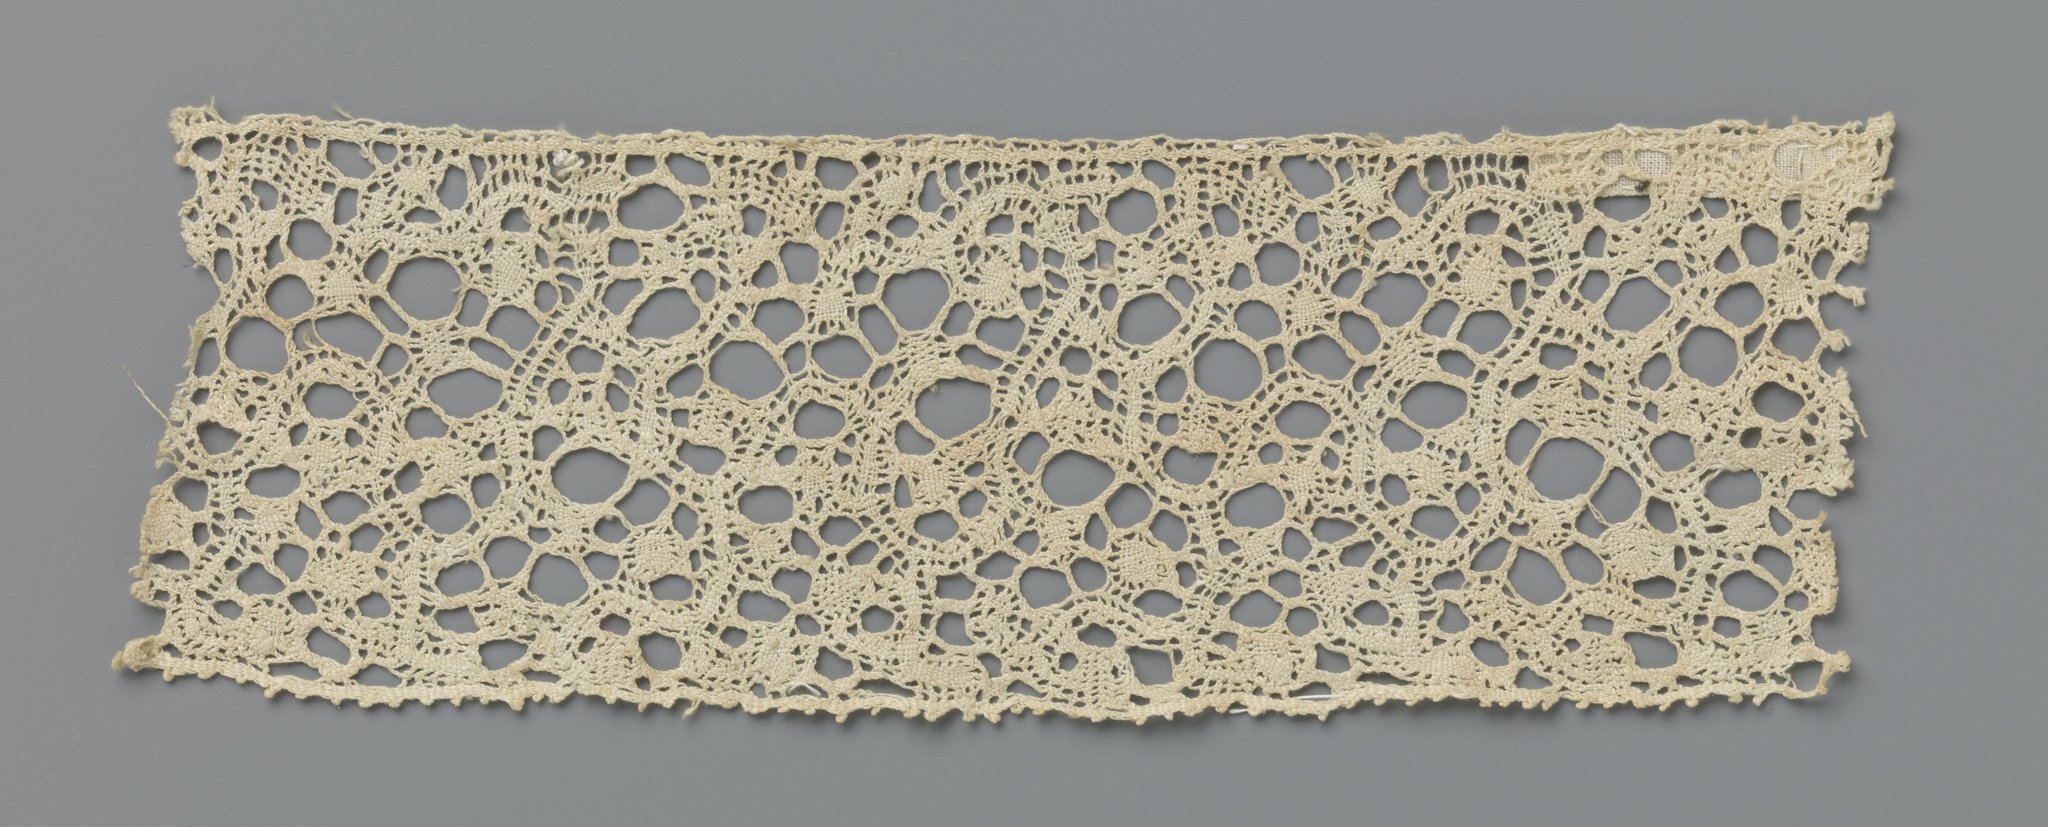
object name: strip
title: Strook kloskant met een wirwar van ovale knopjes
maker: Anonymous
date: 1700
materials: linen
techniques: lace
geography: flanders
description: Strook kloskant, Oud-Vlaamse kant. Het patroon bestaat uit een wirwar van ovale knopjes met veelal c-vormige aanhangsels. De motieven zijn met elkaar verbonden door een vlechtengrond. De motieven zijn gemaakt in linnenslag met opengewerkte randjes. Boven- en onderzijde van de strook zijn recht afgewerkt, waarbij de onderzijde is voorzien van picots.